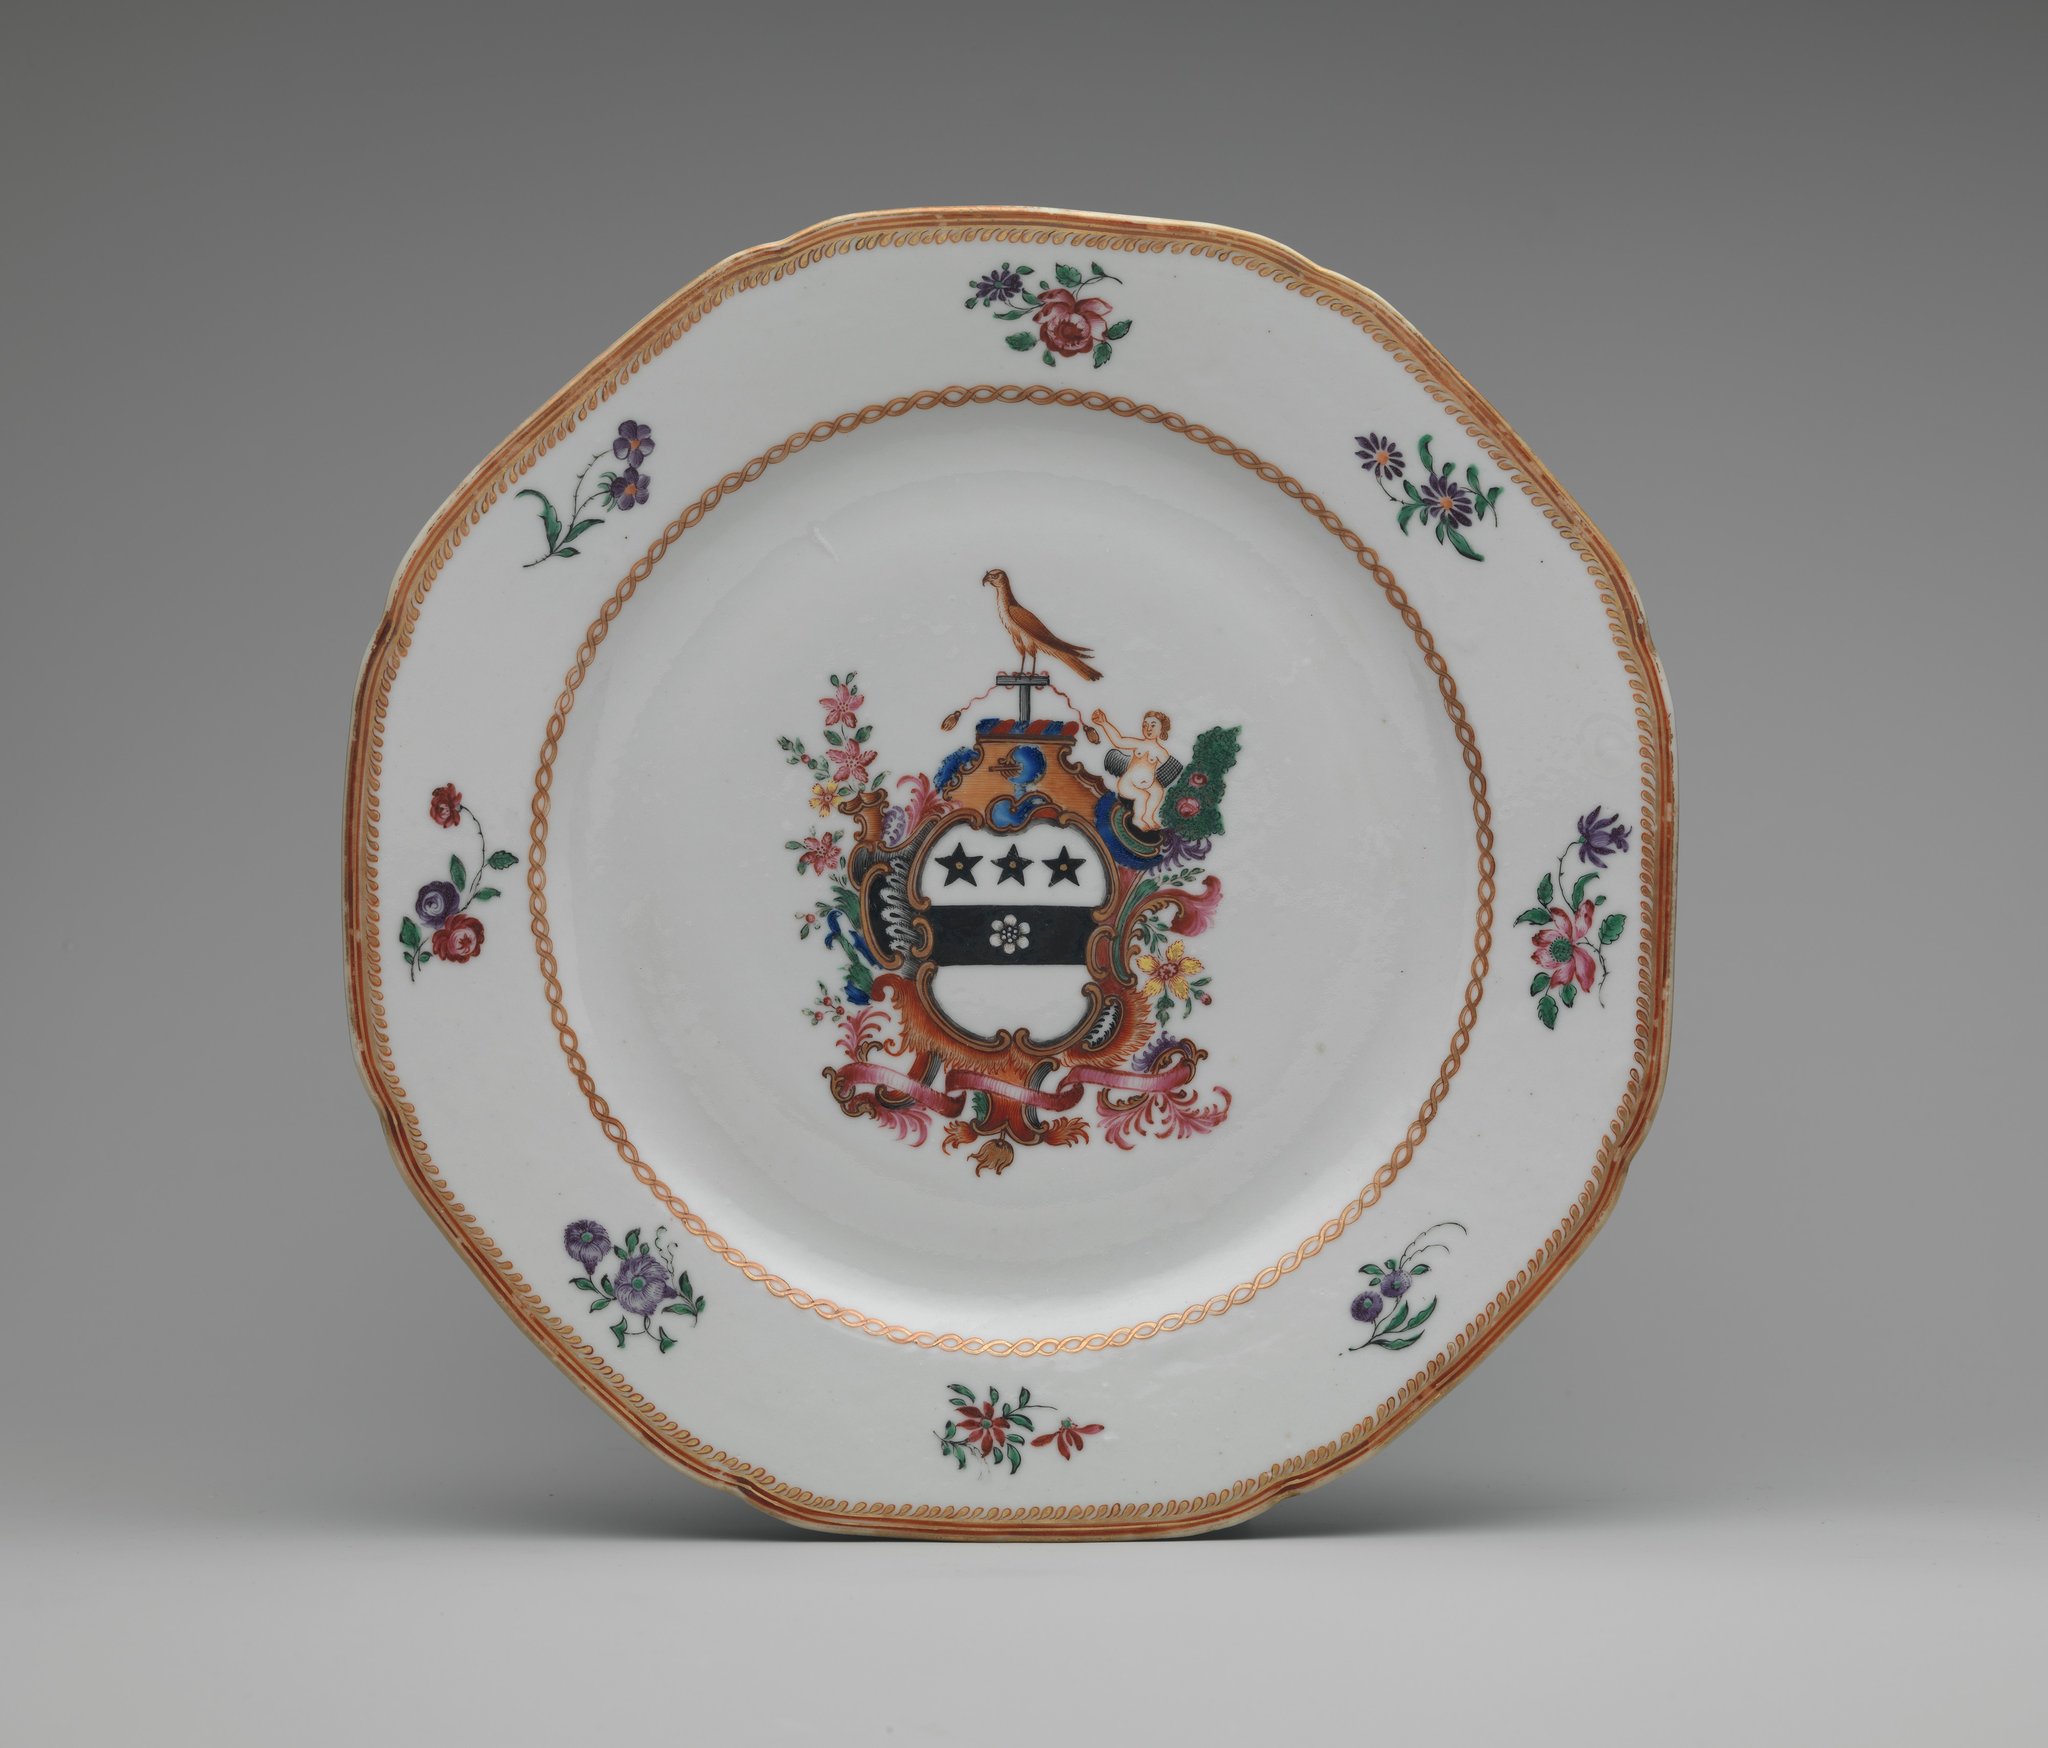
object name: plate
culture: chinese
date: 1785-1790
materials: porcelain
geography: china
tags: birds,coat of arms